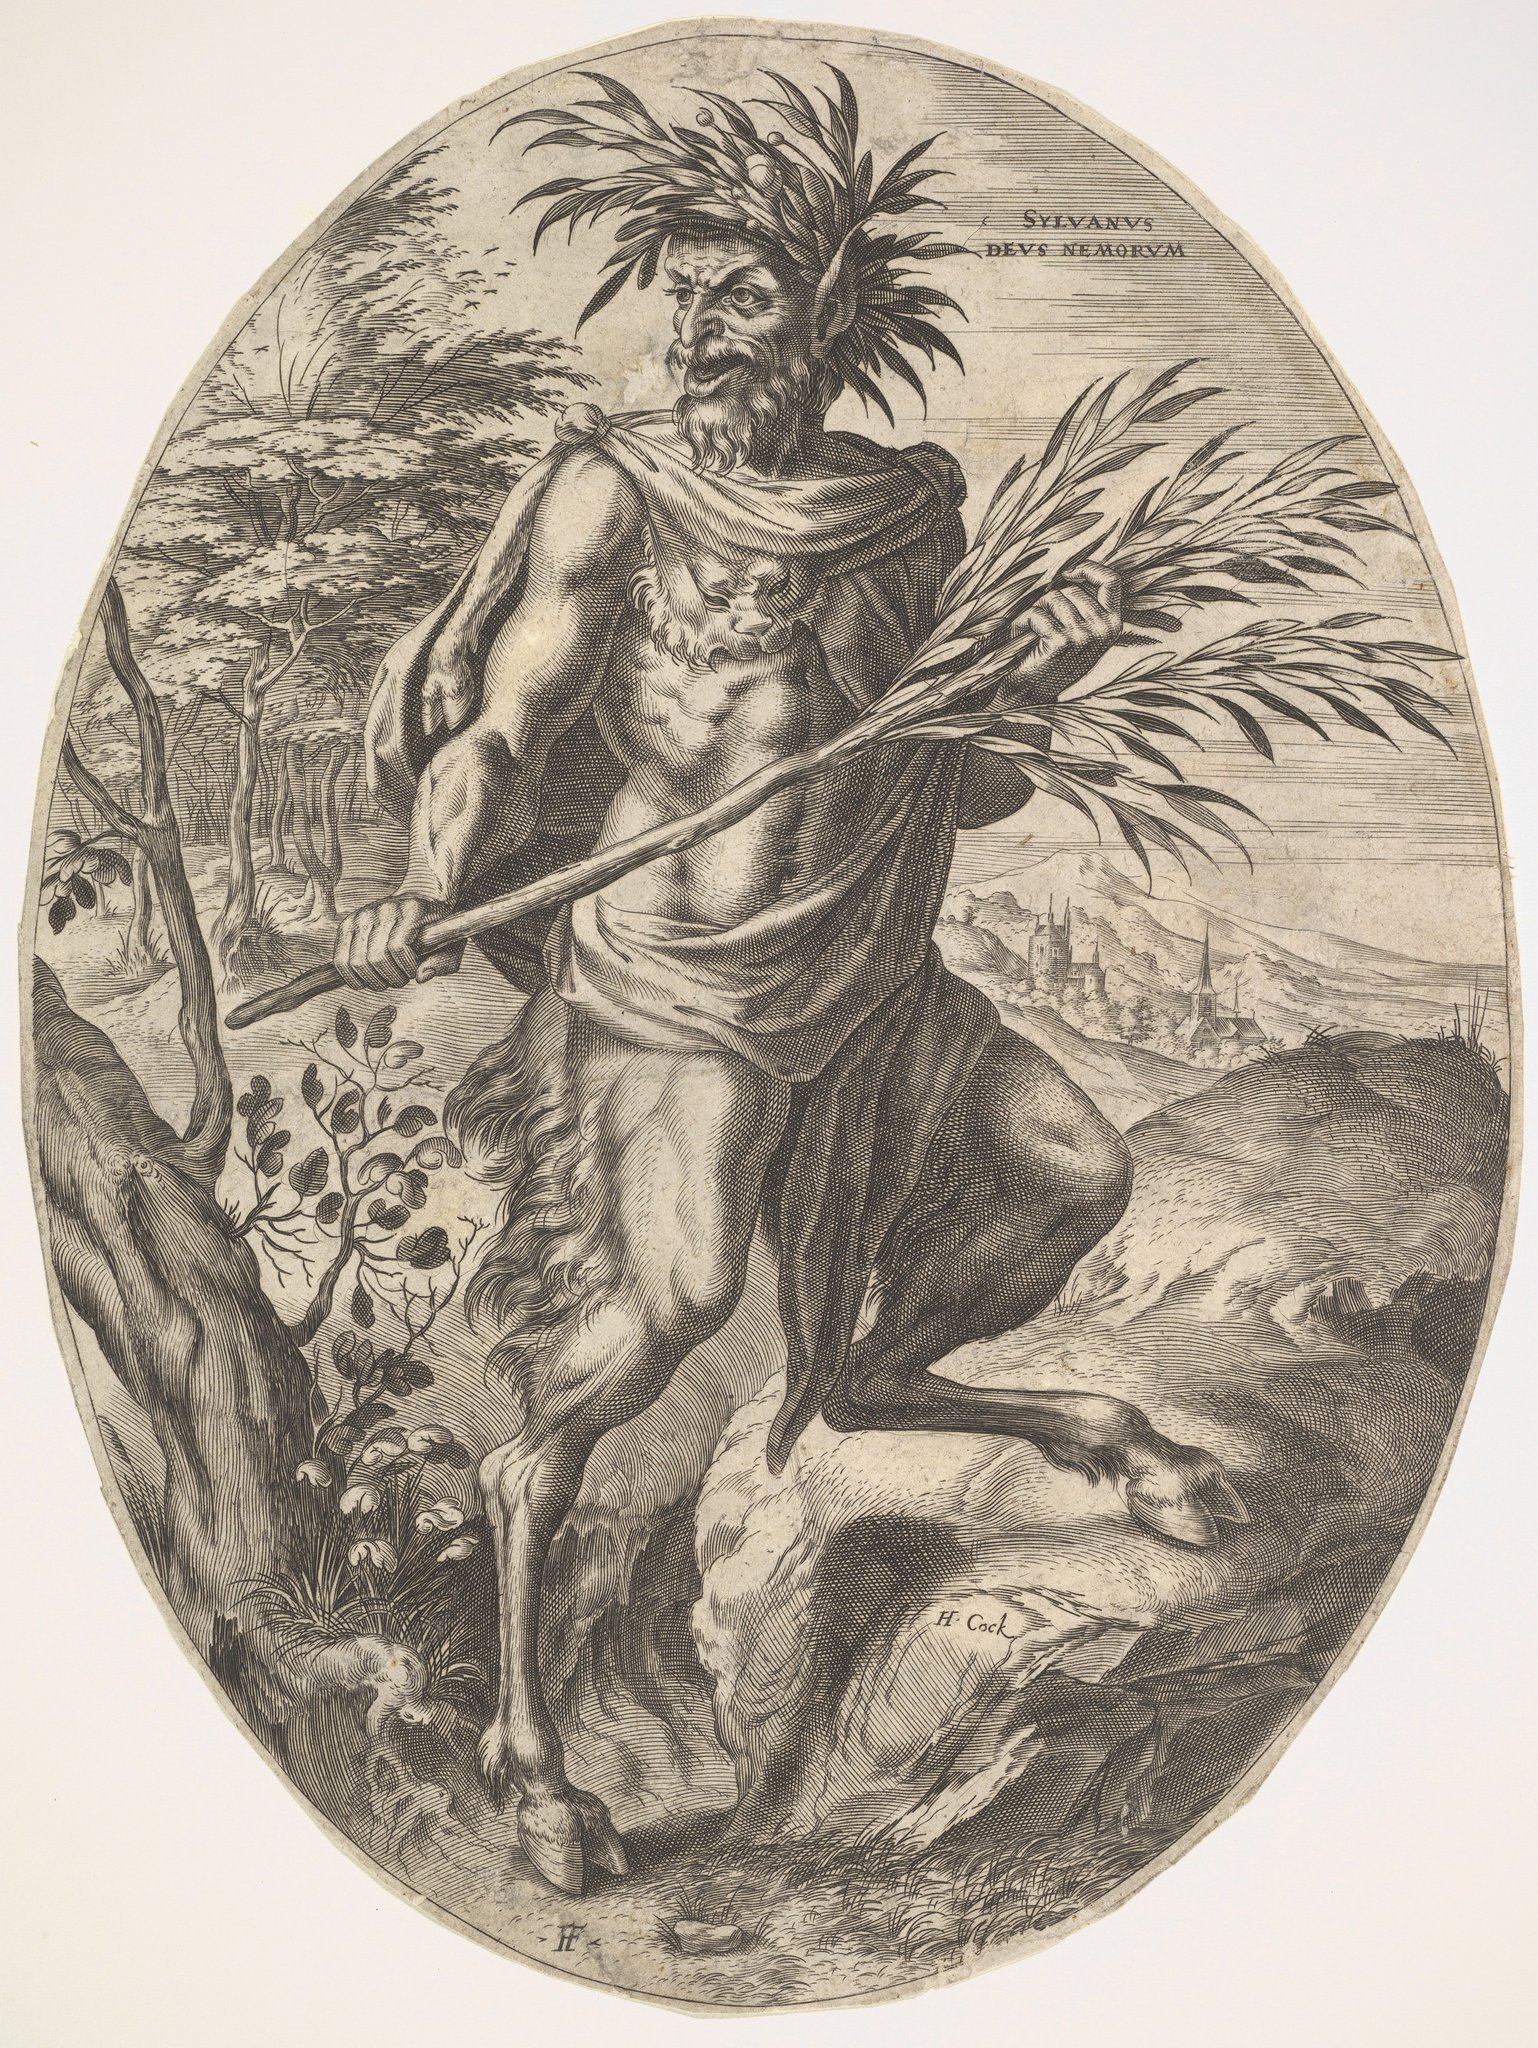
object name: print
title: Sylvanus, from "The Rural Gods"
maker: cornelis cort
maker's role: artist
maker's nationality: netherlandish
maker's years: 1533-1578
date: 1565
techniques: engraving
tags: satyrs